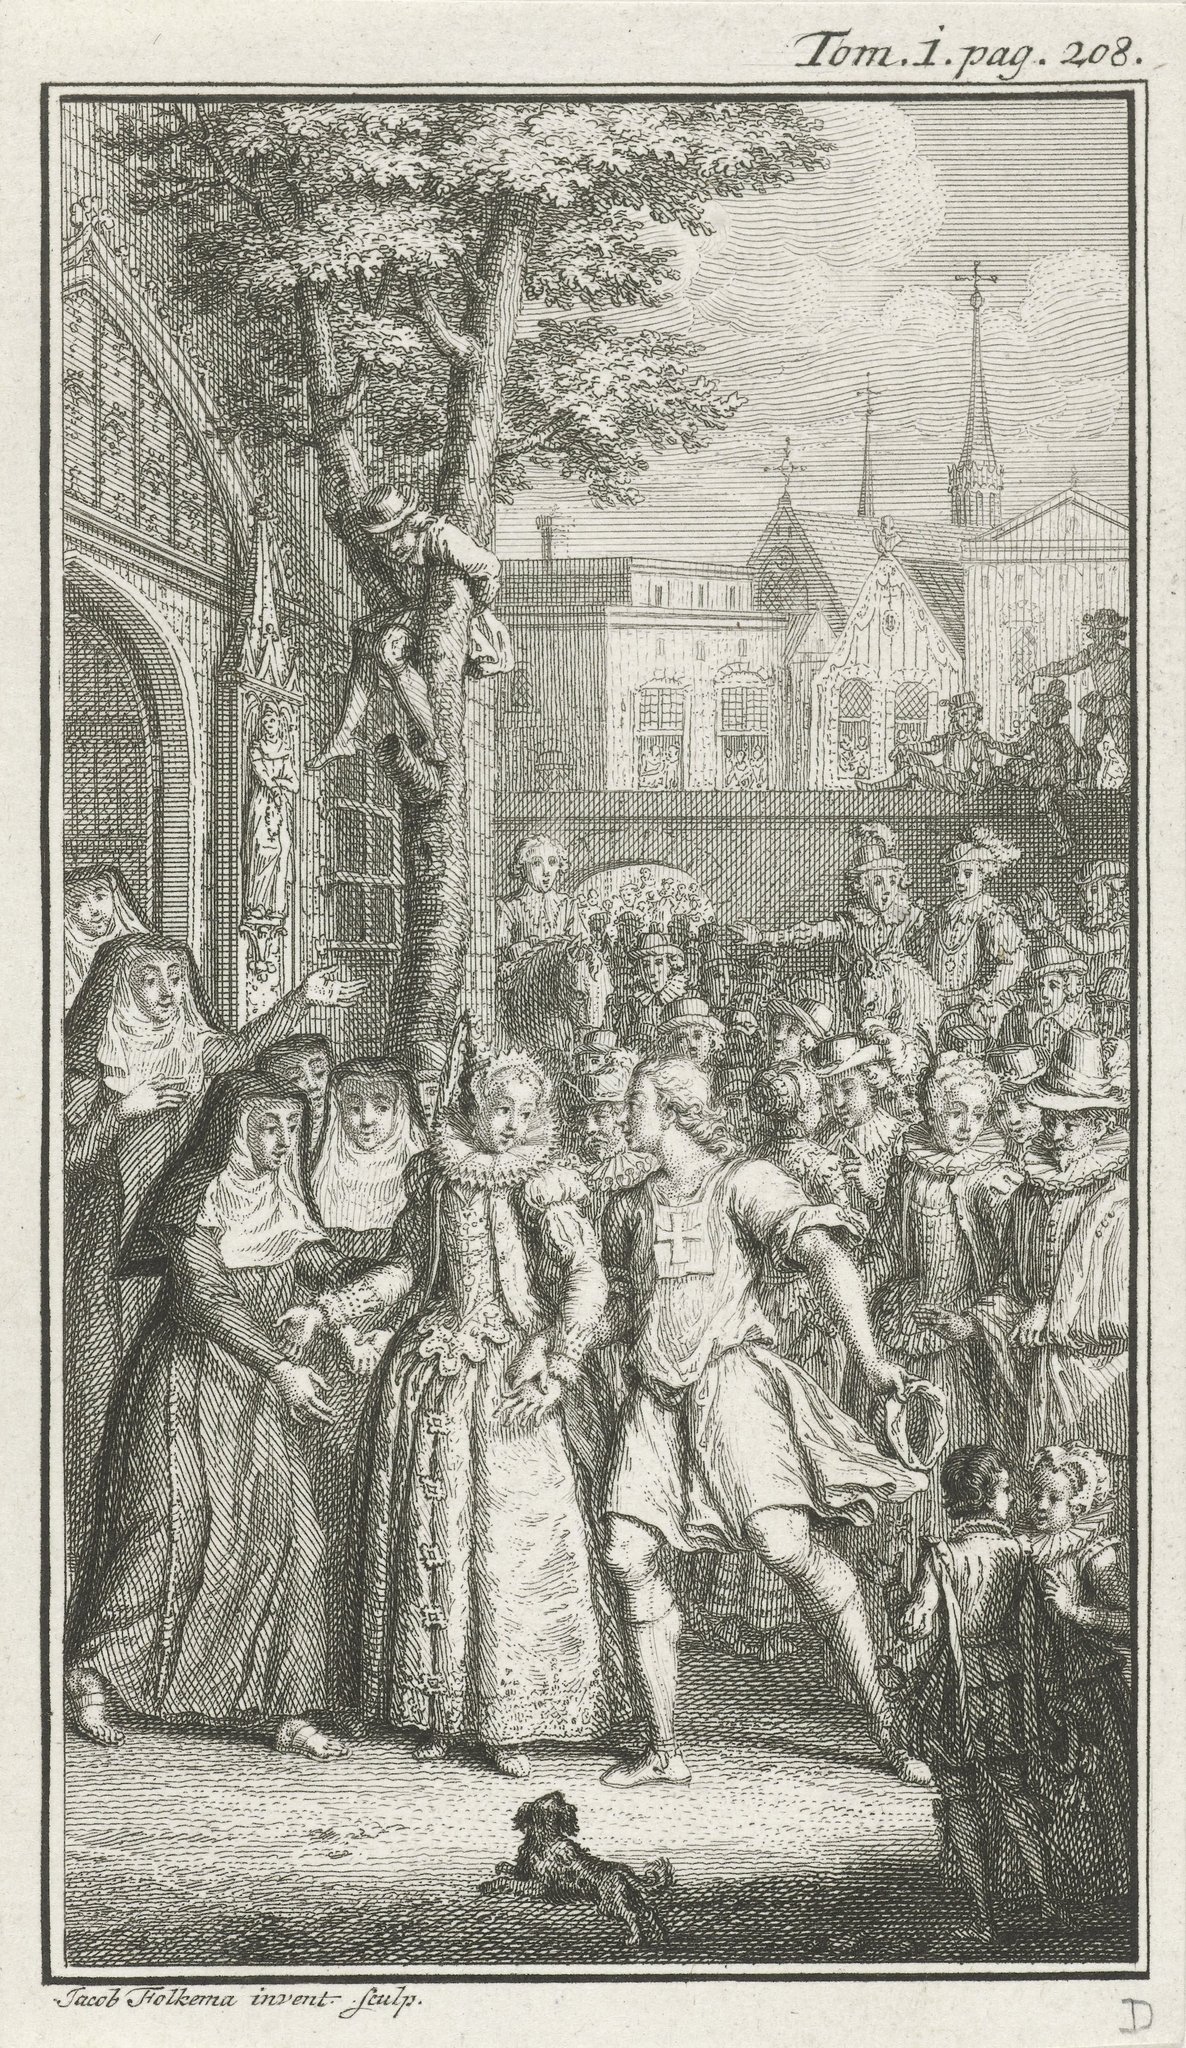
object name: print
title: Rijk geklede vrouw omringd door een menigte nieuwsgierige mensen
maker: jacob folkema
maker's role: draughtsman, print maker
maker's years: 1692-1767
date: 1702-1767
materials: paper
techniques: etching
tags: crowd, mob, nun(s)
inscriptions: collector's mark: Lugt 2228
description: Een rijk geklede vrouw staat tussen een groepje nonnen en een jongeman in. Laatstgenoemde heeft zijn hoed voor de vrouw afgenomen en haar hand vastgepakt. Op de achtergrond heeft een nieuwsgierige menigte zich verzameld. Prent rechtsboven gemerkt: Tom. i. pag. 208.